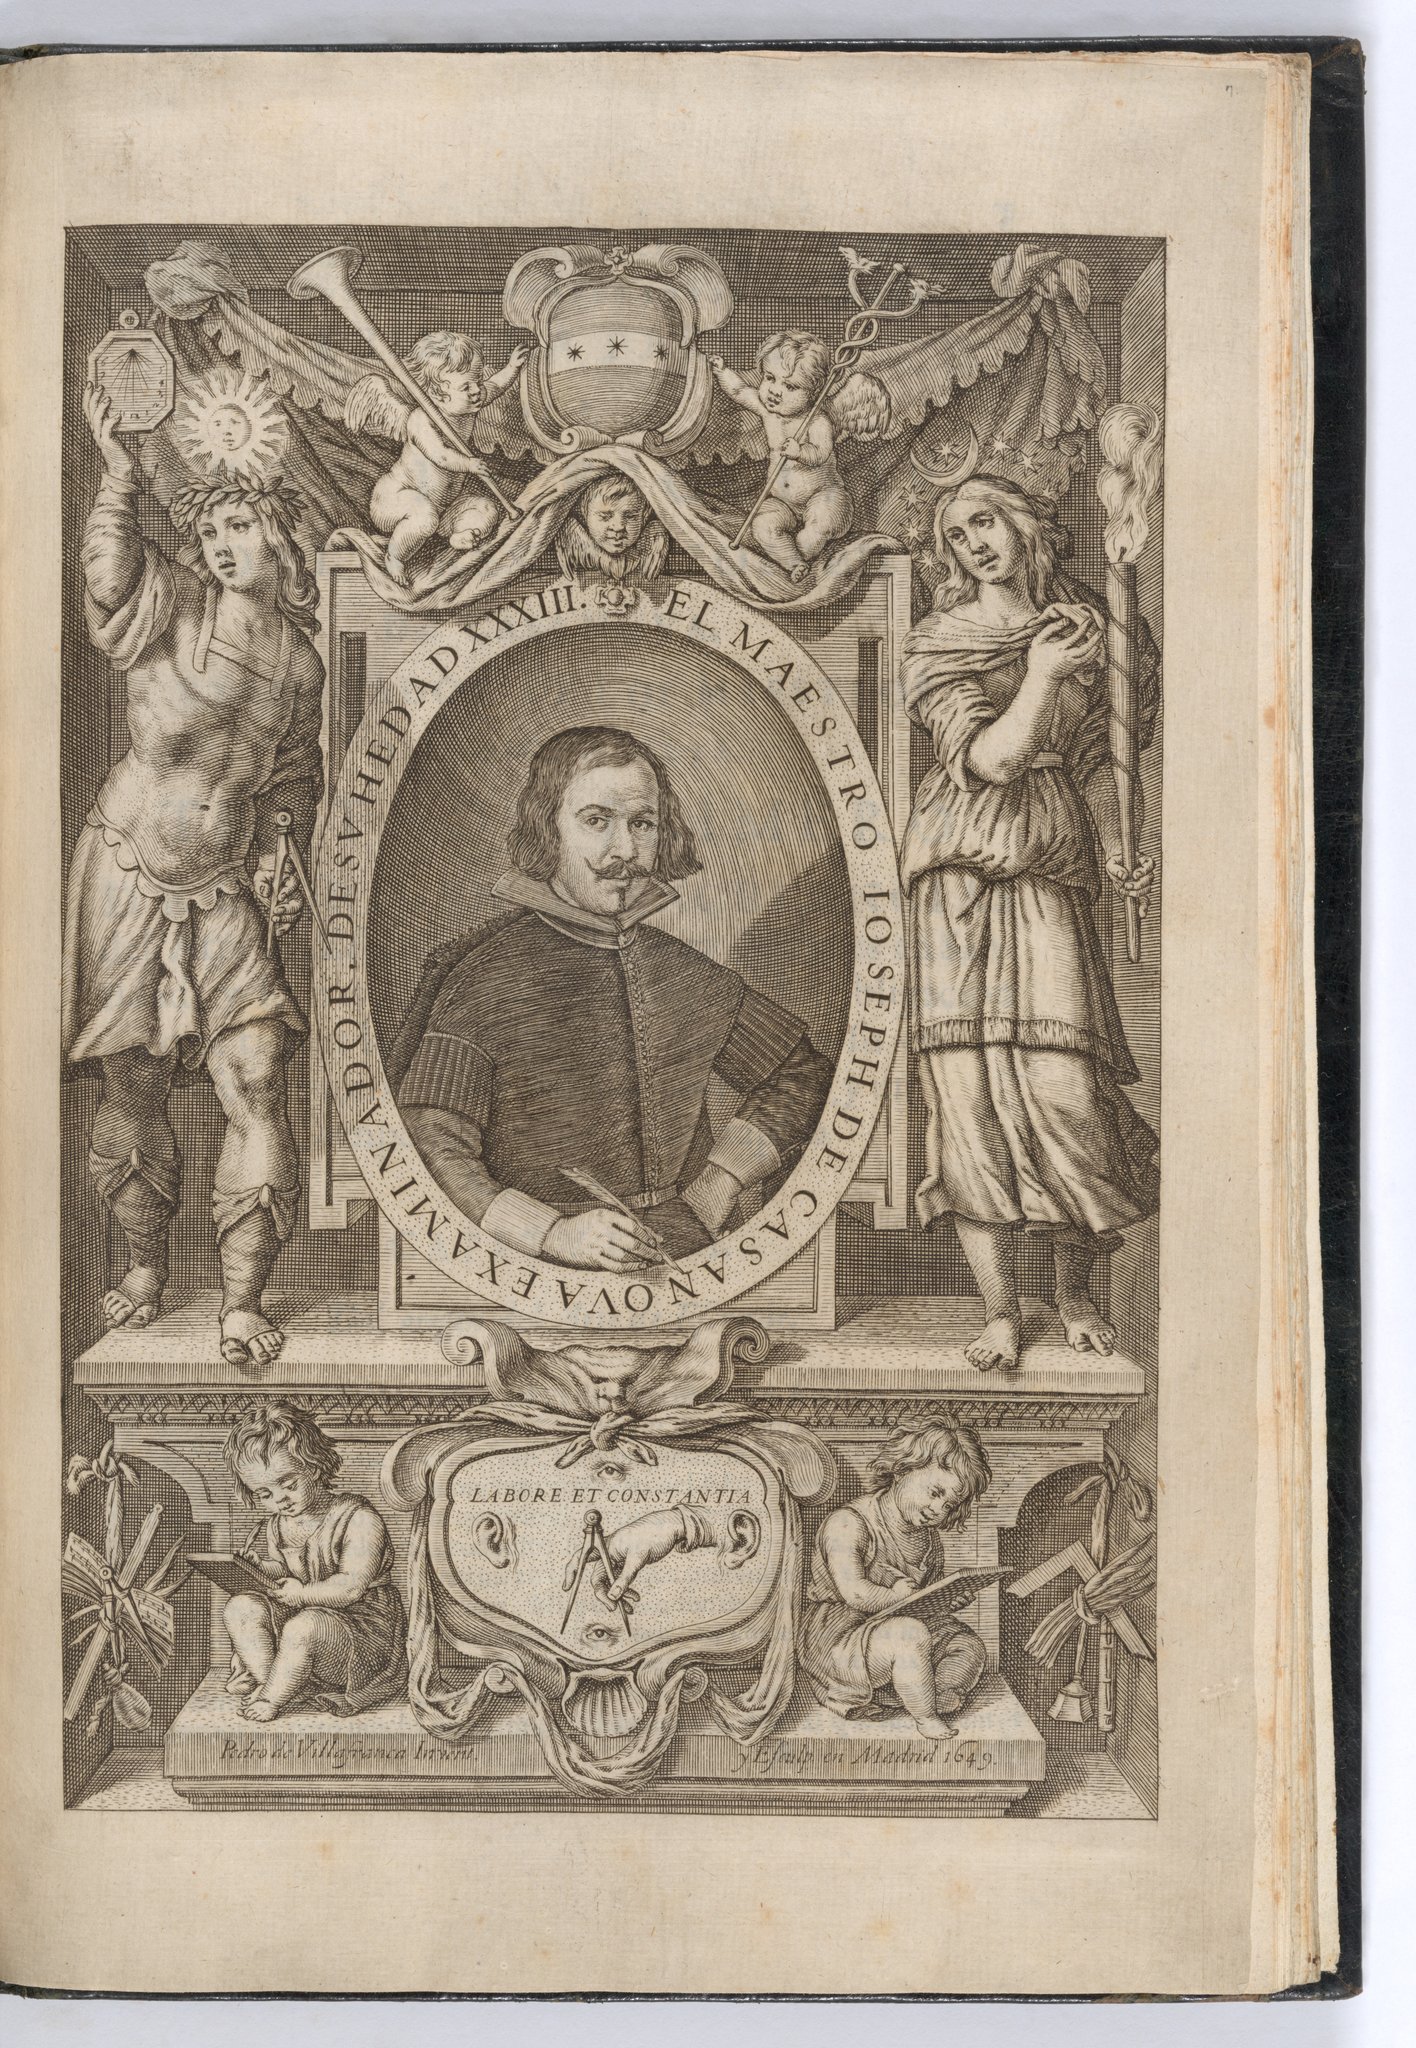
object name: book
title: The writing manual: 'Primera parte del arte de escribir todas formas de letras'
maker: josé de casanova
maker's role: author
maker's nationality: spanish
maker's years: 1613-1692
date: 1650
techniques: engraving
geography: spain